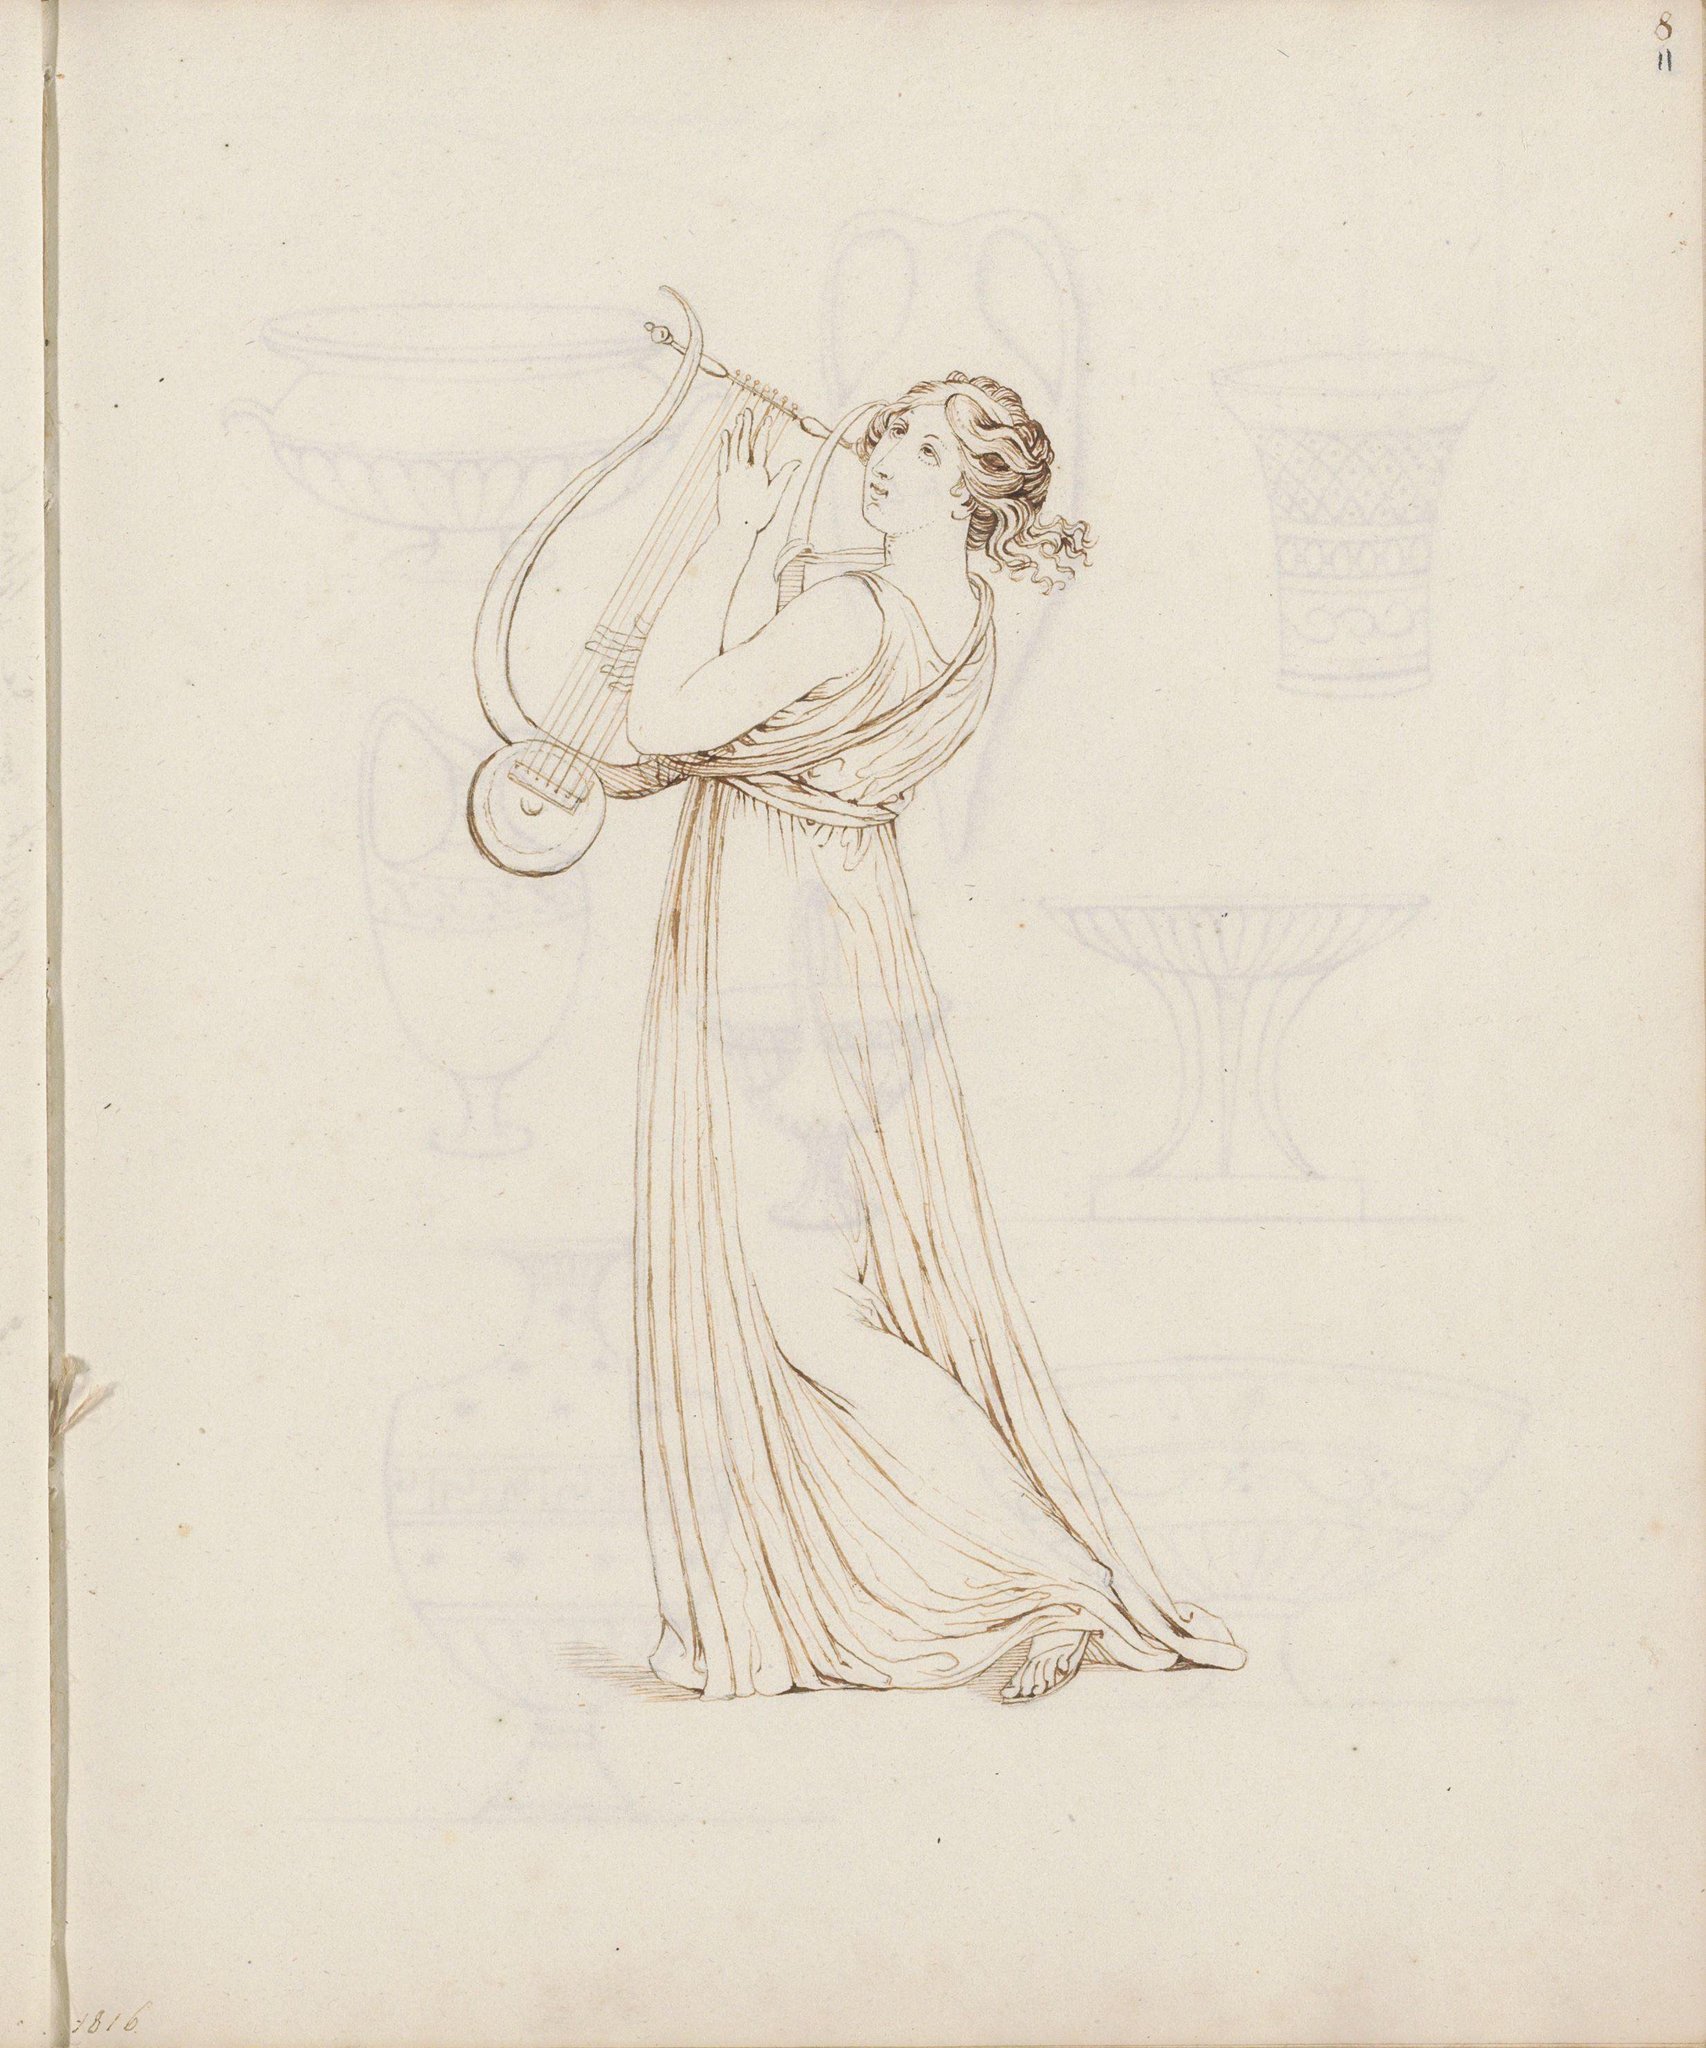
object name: sketchbook leaf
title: Zanggodin die de lier speelt, naar klassiek voorbeeld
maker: jonkvrouw elisabeth kemper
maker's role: draughtsman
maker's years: 1799-1871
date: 1816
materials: ink, paper, pencil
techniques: pen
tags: female persons from classical history (+ belonging to greek history), lyre, cithara, psaltery (+ artist at work)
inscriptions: date: ‘1816’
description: De vrouw draagt een tuniek. Blad 11 recto uit een schetsboek met 94 bladen.